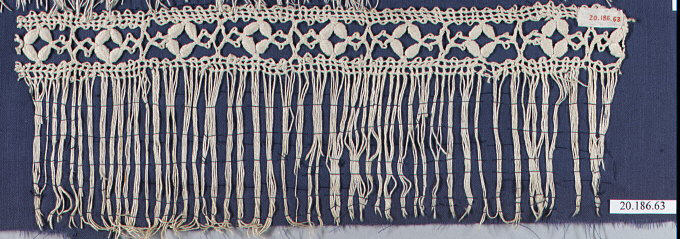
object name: edging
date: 1501-1600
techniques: lace